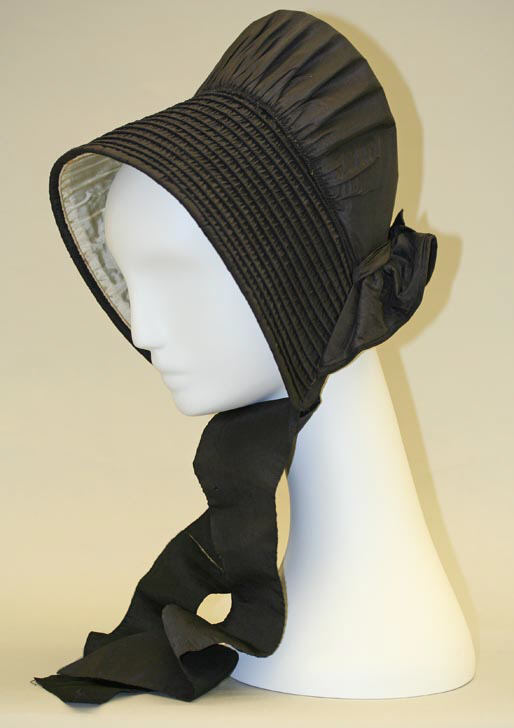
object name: bonnet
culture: american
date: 1801-1900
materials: silk